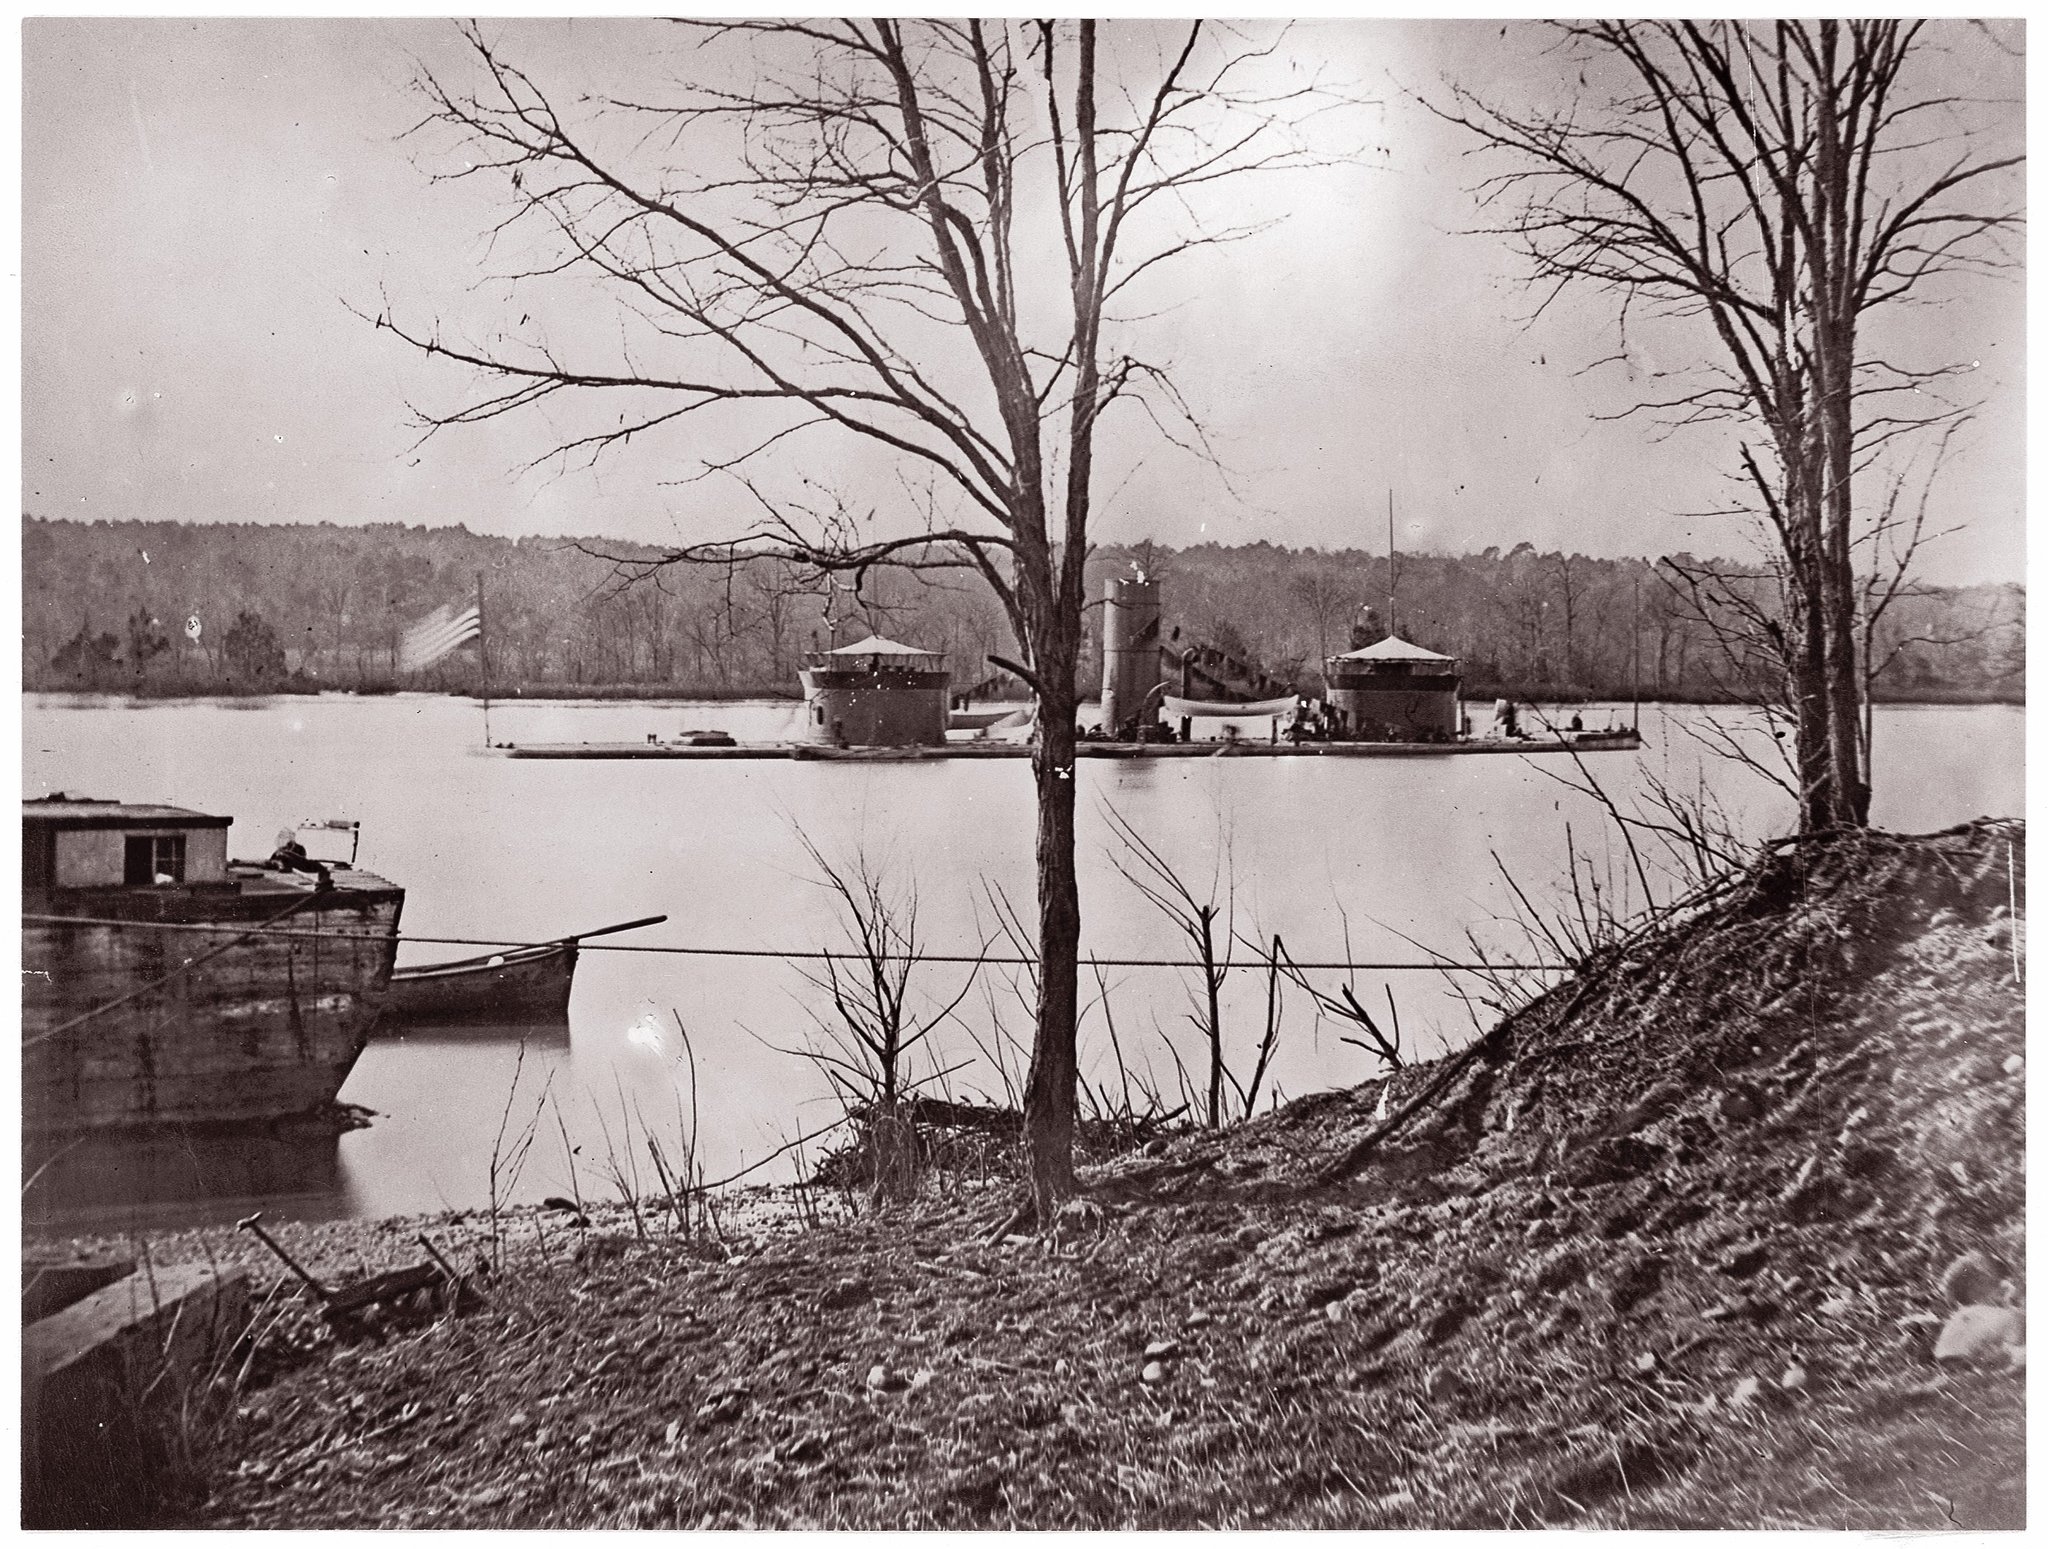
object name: photograph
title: U.S. Monitor Onondaga, James River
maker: Anonymous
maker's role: artist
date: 1861-1865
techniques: albumen silver print, glass negative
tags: american civil war,rivers,boats